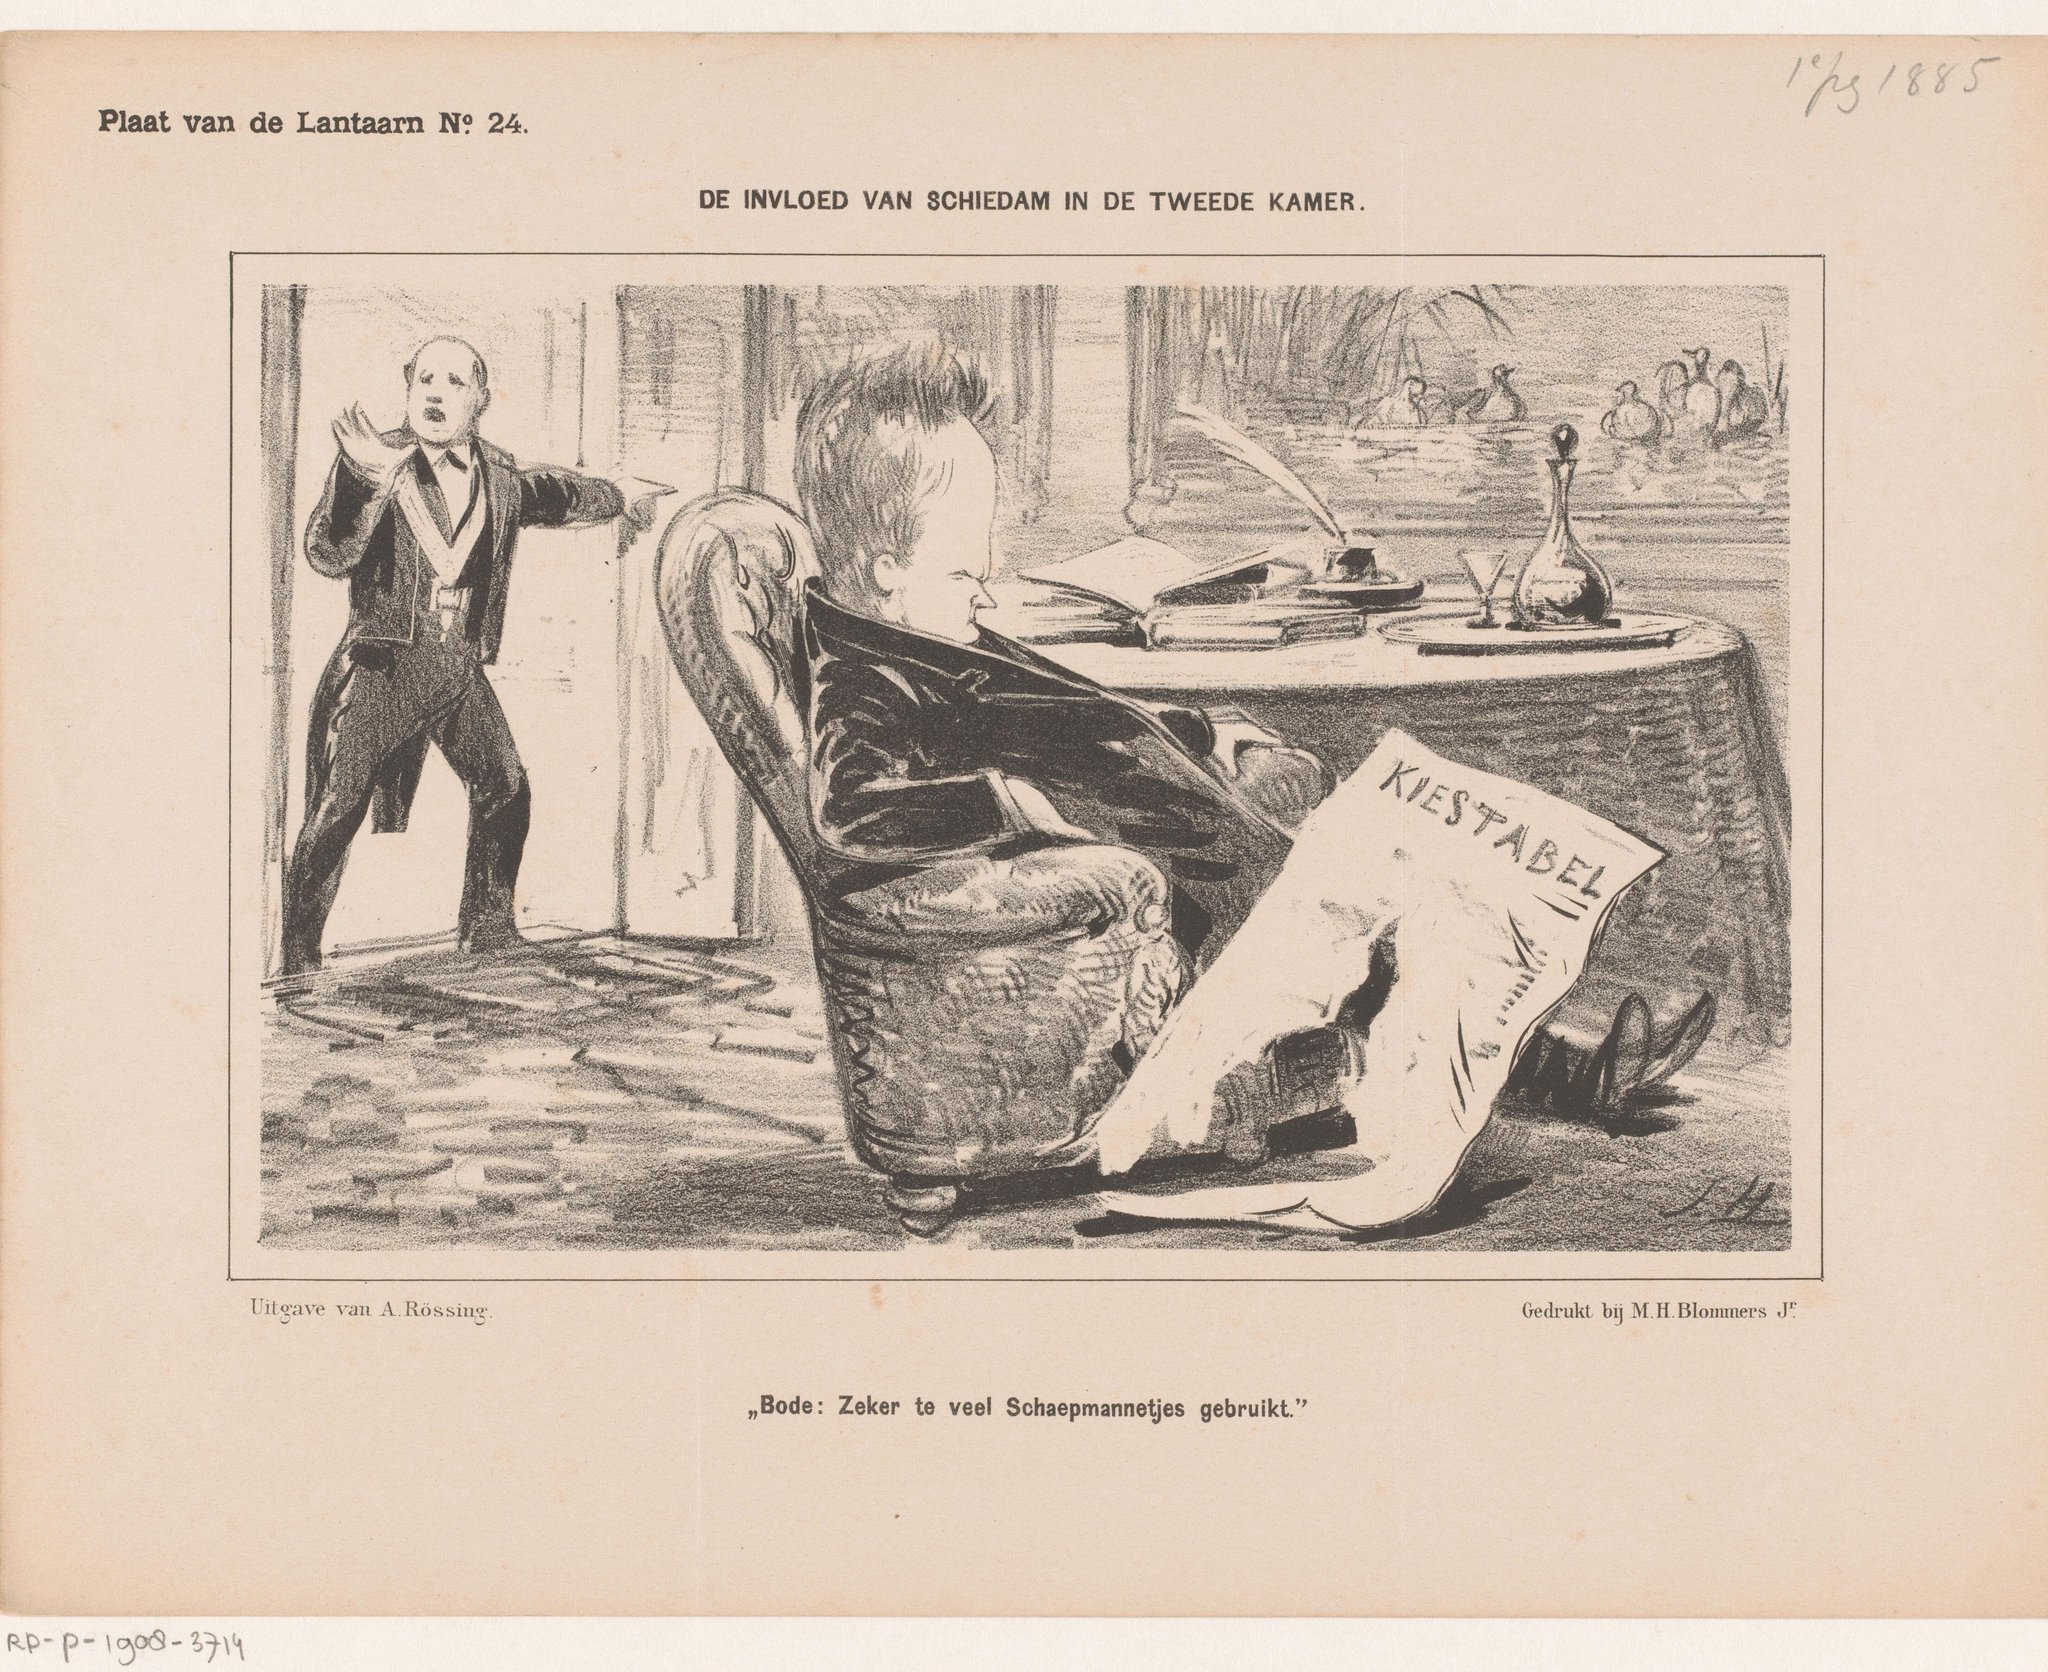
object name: cartoon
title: De invloed van Schiedam in de Tweede Kamer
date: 1885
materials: paper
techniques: lithograph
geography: netherlands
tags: rome, priest, herman johannes aloysius maria schaepman, the hague, drunkenness, alcoholic drinks, political caricatures and satires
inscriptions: collector's mark: Lugt 2228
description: Minister president Van Heemskerk Azn. zit onderuit gezakt en dronken in een stoel. Voor hem ligt een gescheurd vel papier met daarop 'Kiestabel'. De titel verwijst naar het voorstel om van Schiedam een afzonderlijk kiesdistrict te maken. In het onderschrift wordt verwezen naar Herman Schaepman en zijn 'twee borrels daags'. Toen hij in 1881 zijn intrede deed in de Tweede Kamer hield hij een vurig pleidooi tegen de drankwet. Later gaf hij, tot veler verbazing, toe dat twee borrels per dag wel gegund waren aan arbeiders. Deze twee borrels werden sindsdien aangeduid als 'Schaepmannetjes'. Deze prent werd uitgegeven bij De Lantaarn.